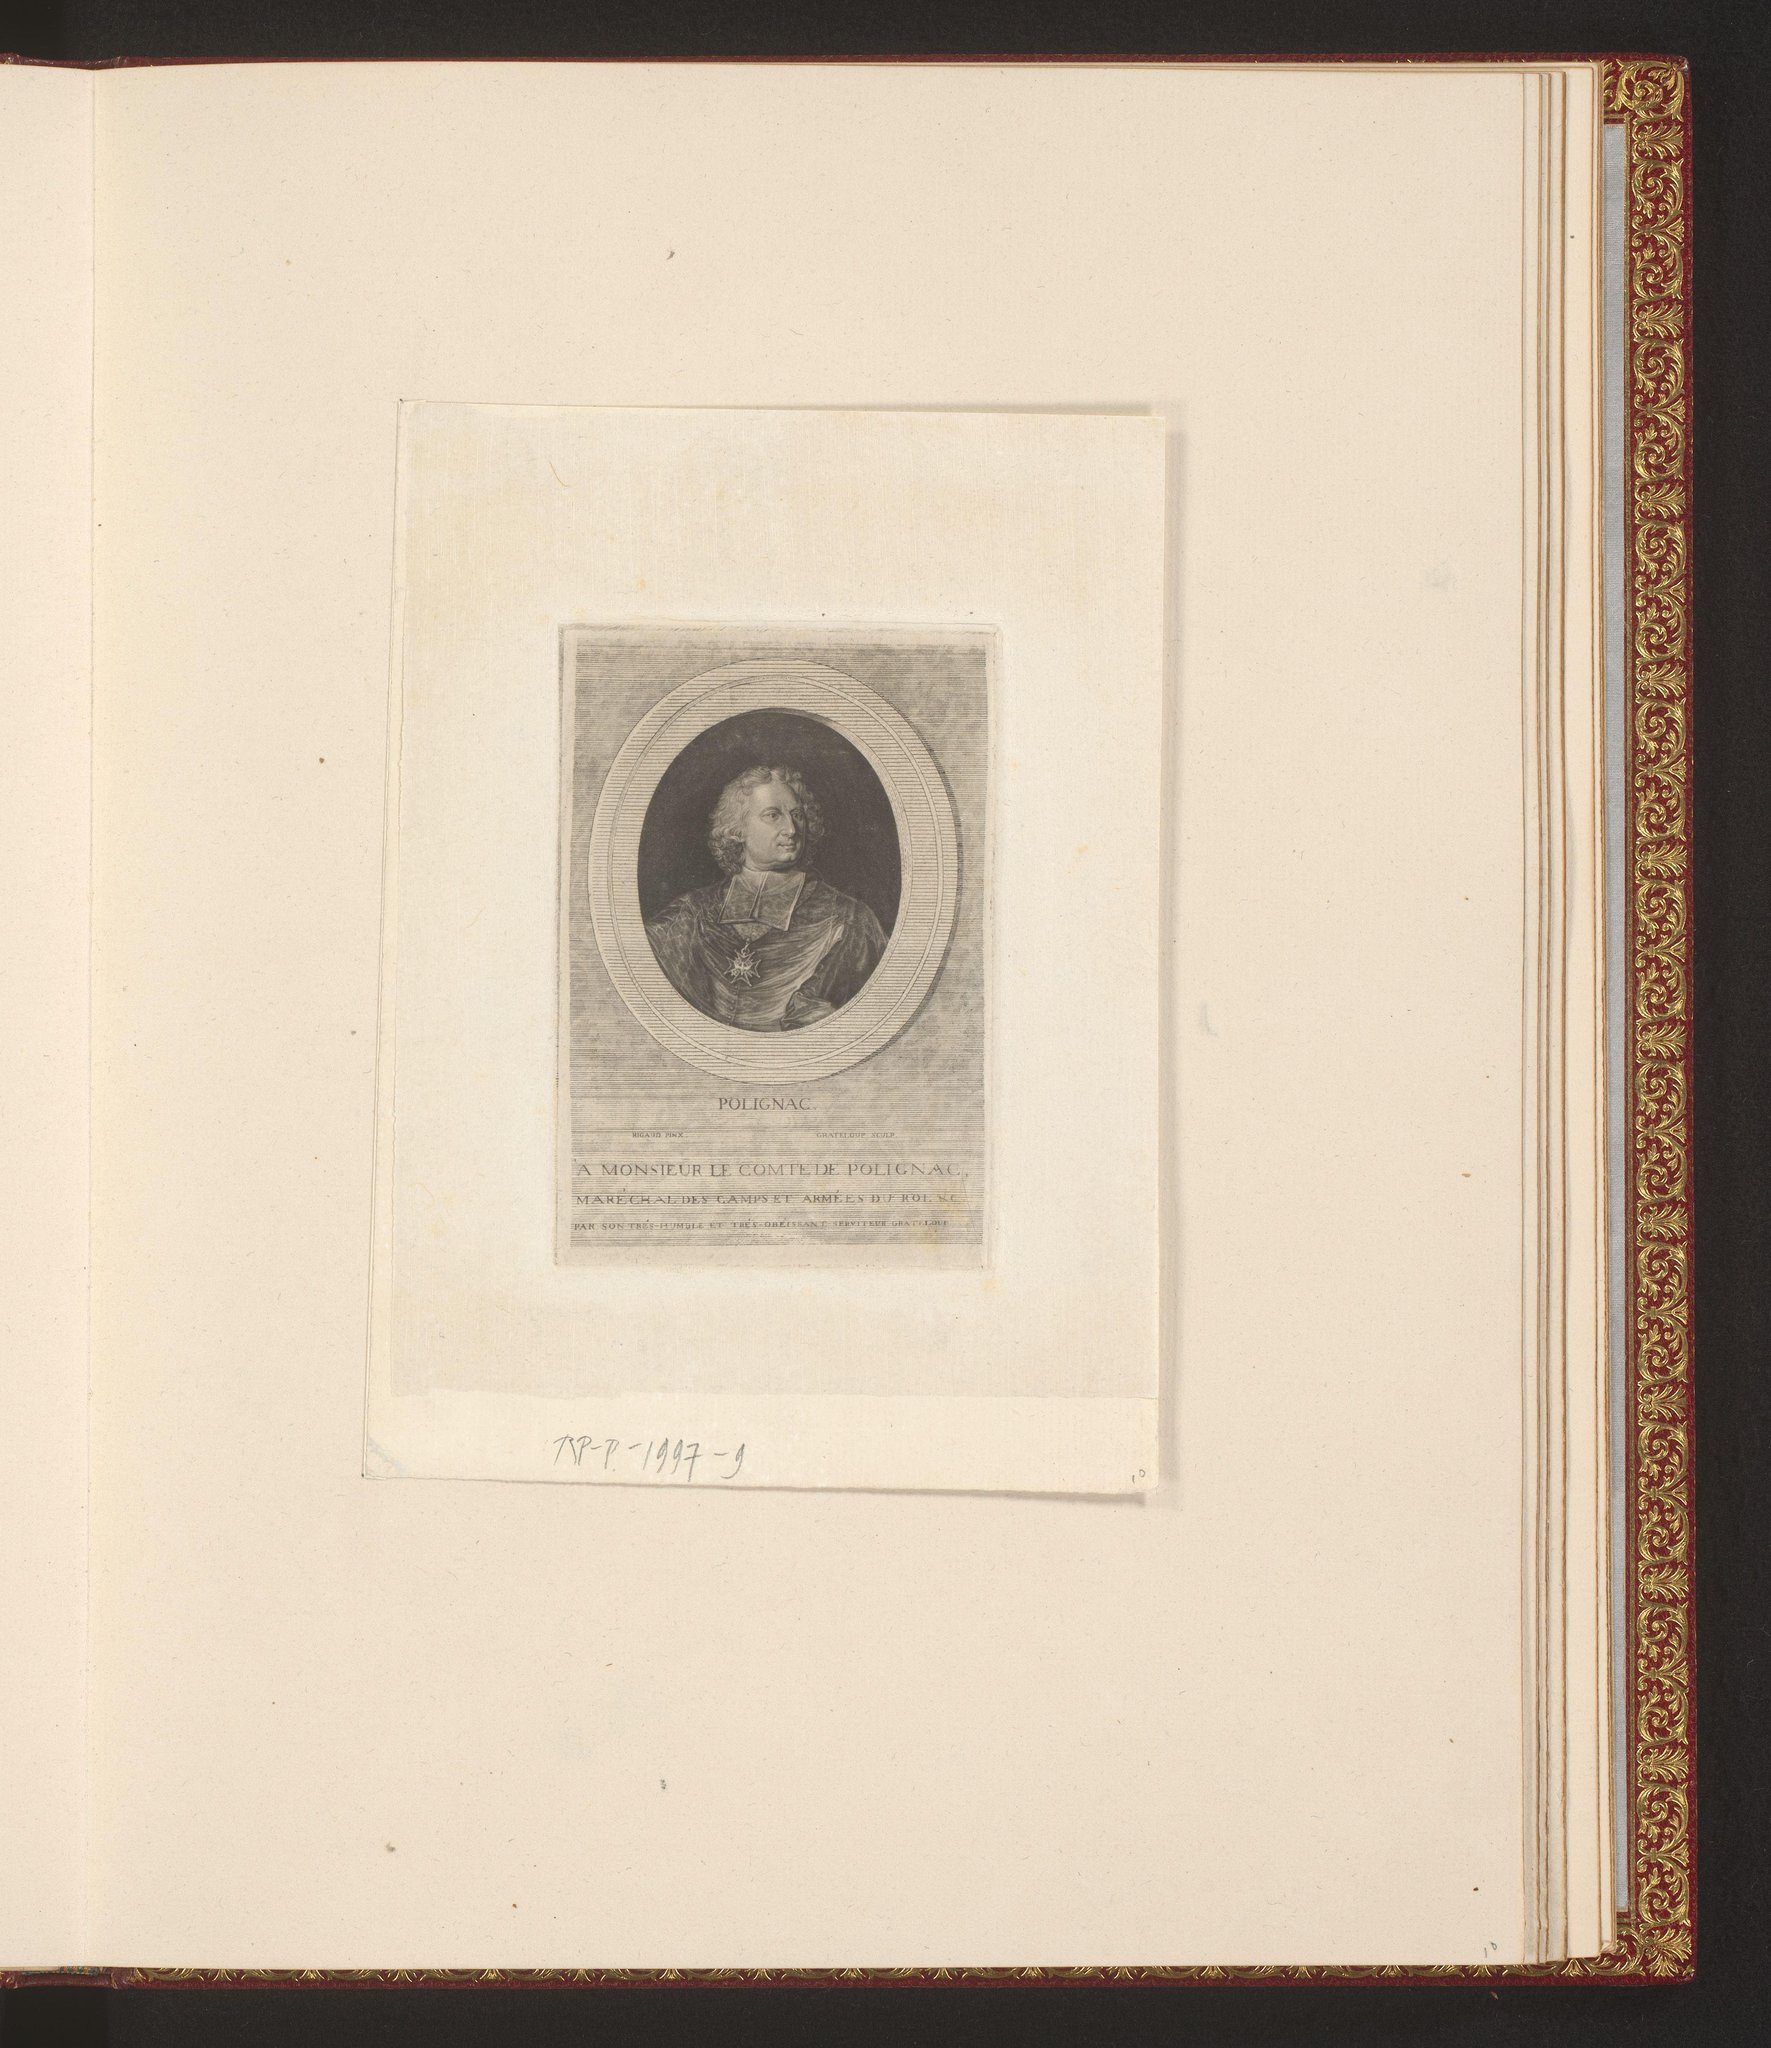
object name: print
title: Polignac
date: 1765-1767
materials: paper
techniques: aquatint, etching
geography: france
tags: france, paris, melchior de polignac, cardinal, historical persons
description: Jean-Baptiste de Grateloup gebruikte een geheim proces bij het maken van zijn prenten, lijkend op aquatint. Zijn neef Jean-Pierre Sylvestre de Grateloup heeft ook op deze manier gewerkt.